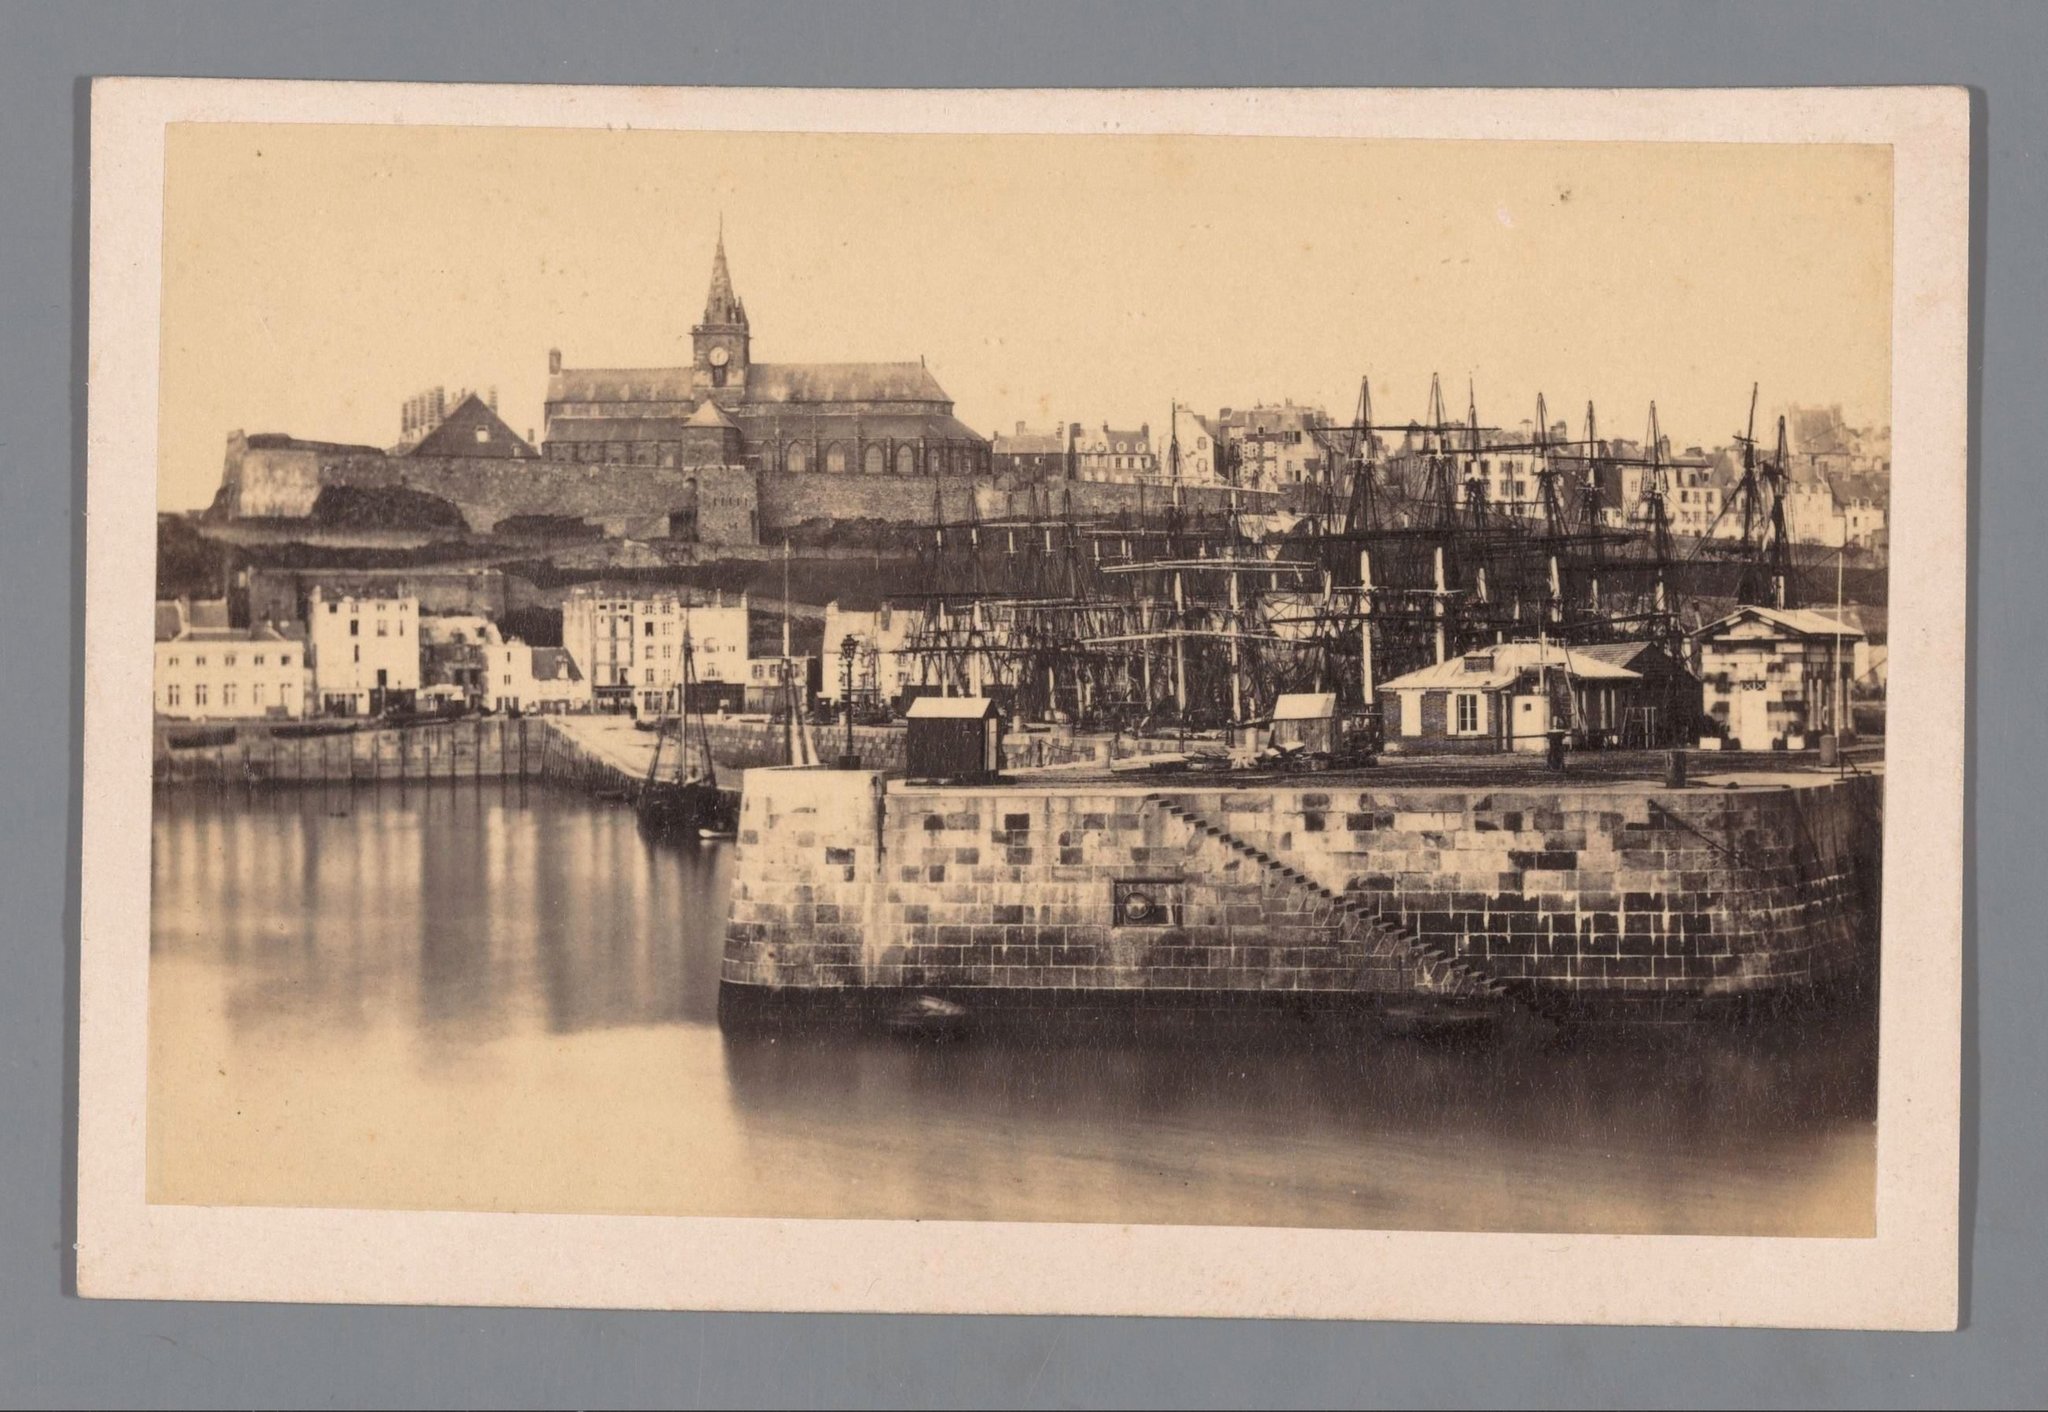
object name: photograph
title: Gezicht op de haven van Granville, Frankrijk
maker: Anonymous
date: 1860-1880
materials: paper, photographic support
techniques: albumen print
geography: france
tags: granville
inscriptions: annotation: ‘Granville / 27 juin / 78 / Manche [?] 326 [...]’